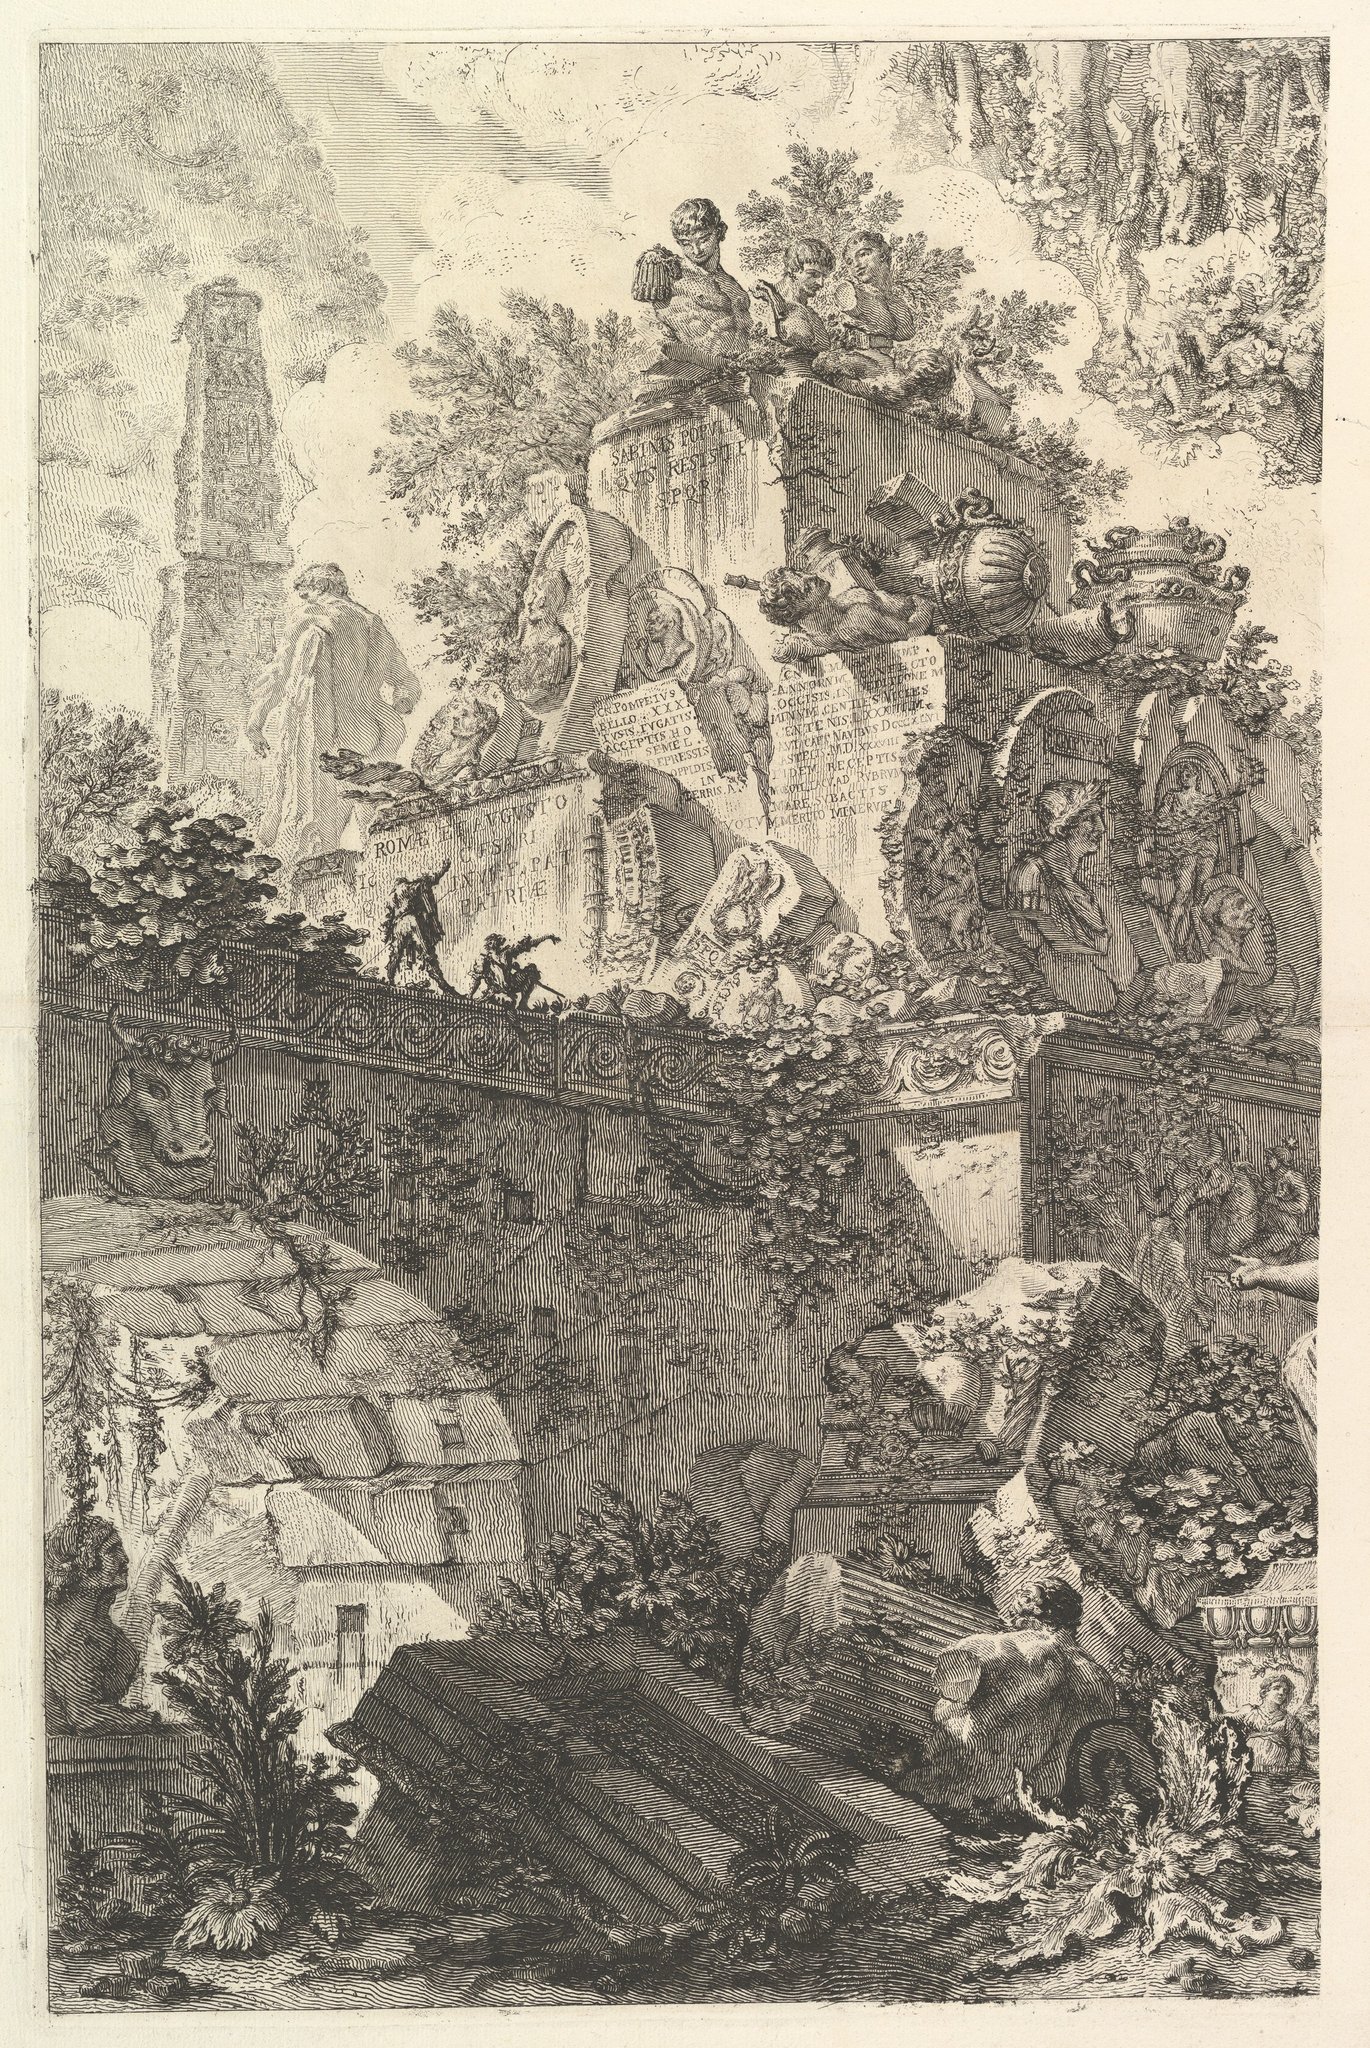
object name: print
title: Frontispiece, with Statue of Minerva, from "Vedute di Roma"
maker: giovanni battista piranesi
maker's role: artist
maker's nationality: italian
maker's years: 1720-1778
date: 1748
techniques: etching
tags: sculpture,obelisks,minerva